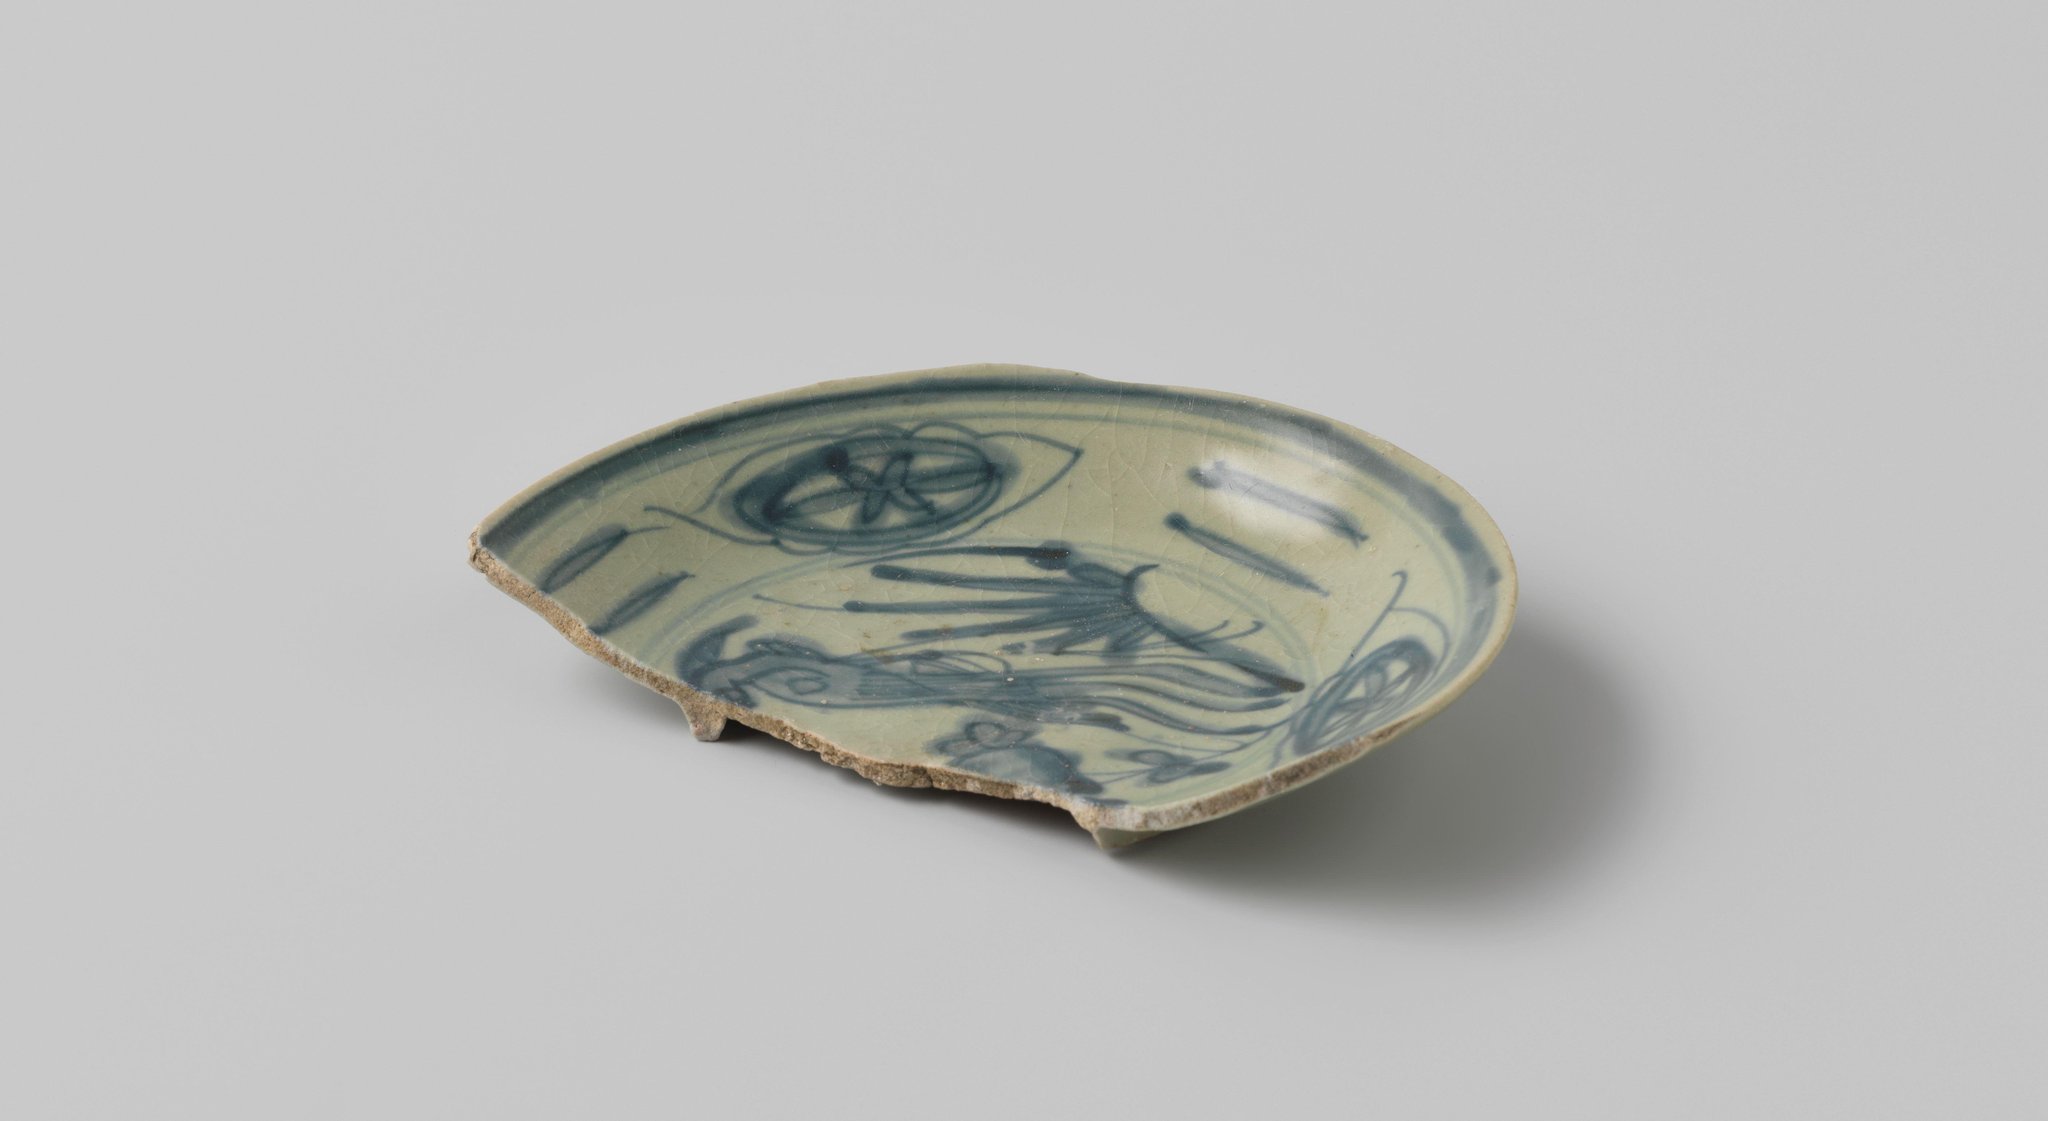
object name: plate dish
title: Fragment bord uit V.O.C.-schip de 'Witte Leeuw'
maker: Anonymous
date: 1613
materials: porcelain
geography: shantou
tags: verenigde oostindische compagnie, sint-helena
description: A dish. In the centre, a standing phoenix with a peony on the left and bamboo on the right. The walls have four oval medallions in diamond shaped frames filled with rosettes and separated by a parody of trigrams. Around the lip-rim is a band of key-fret under blue. The exterior is plain.